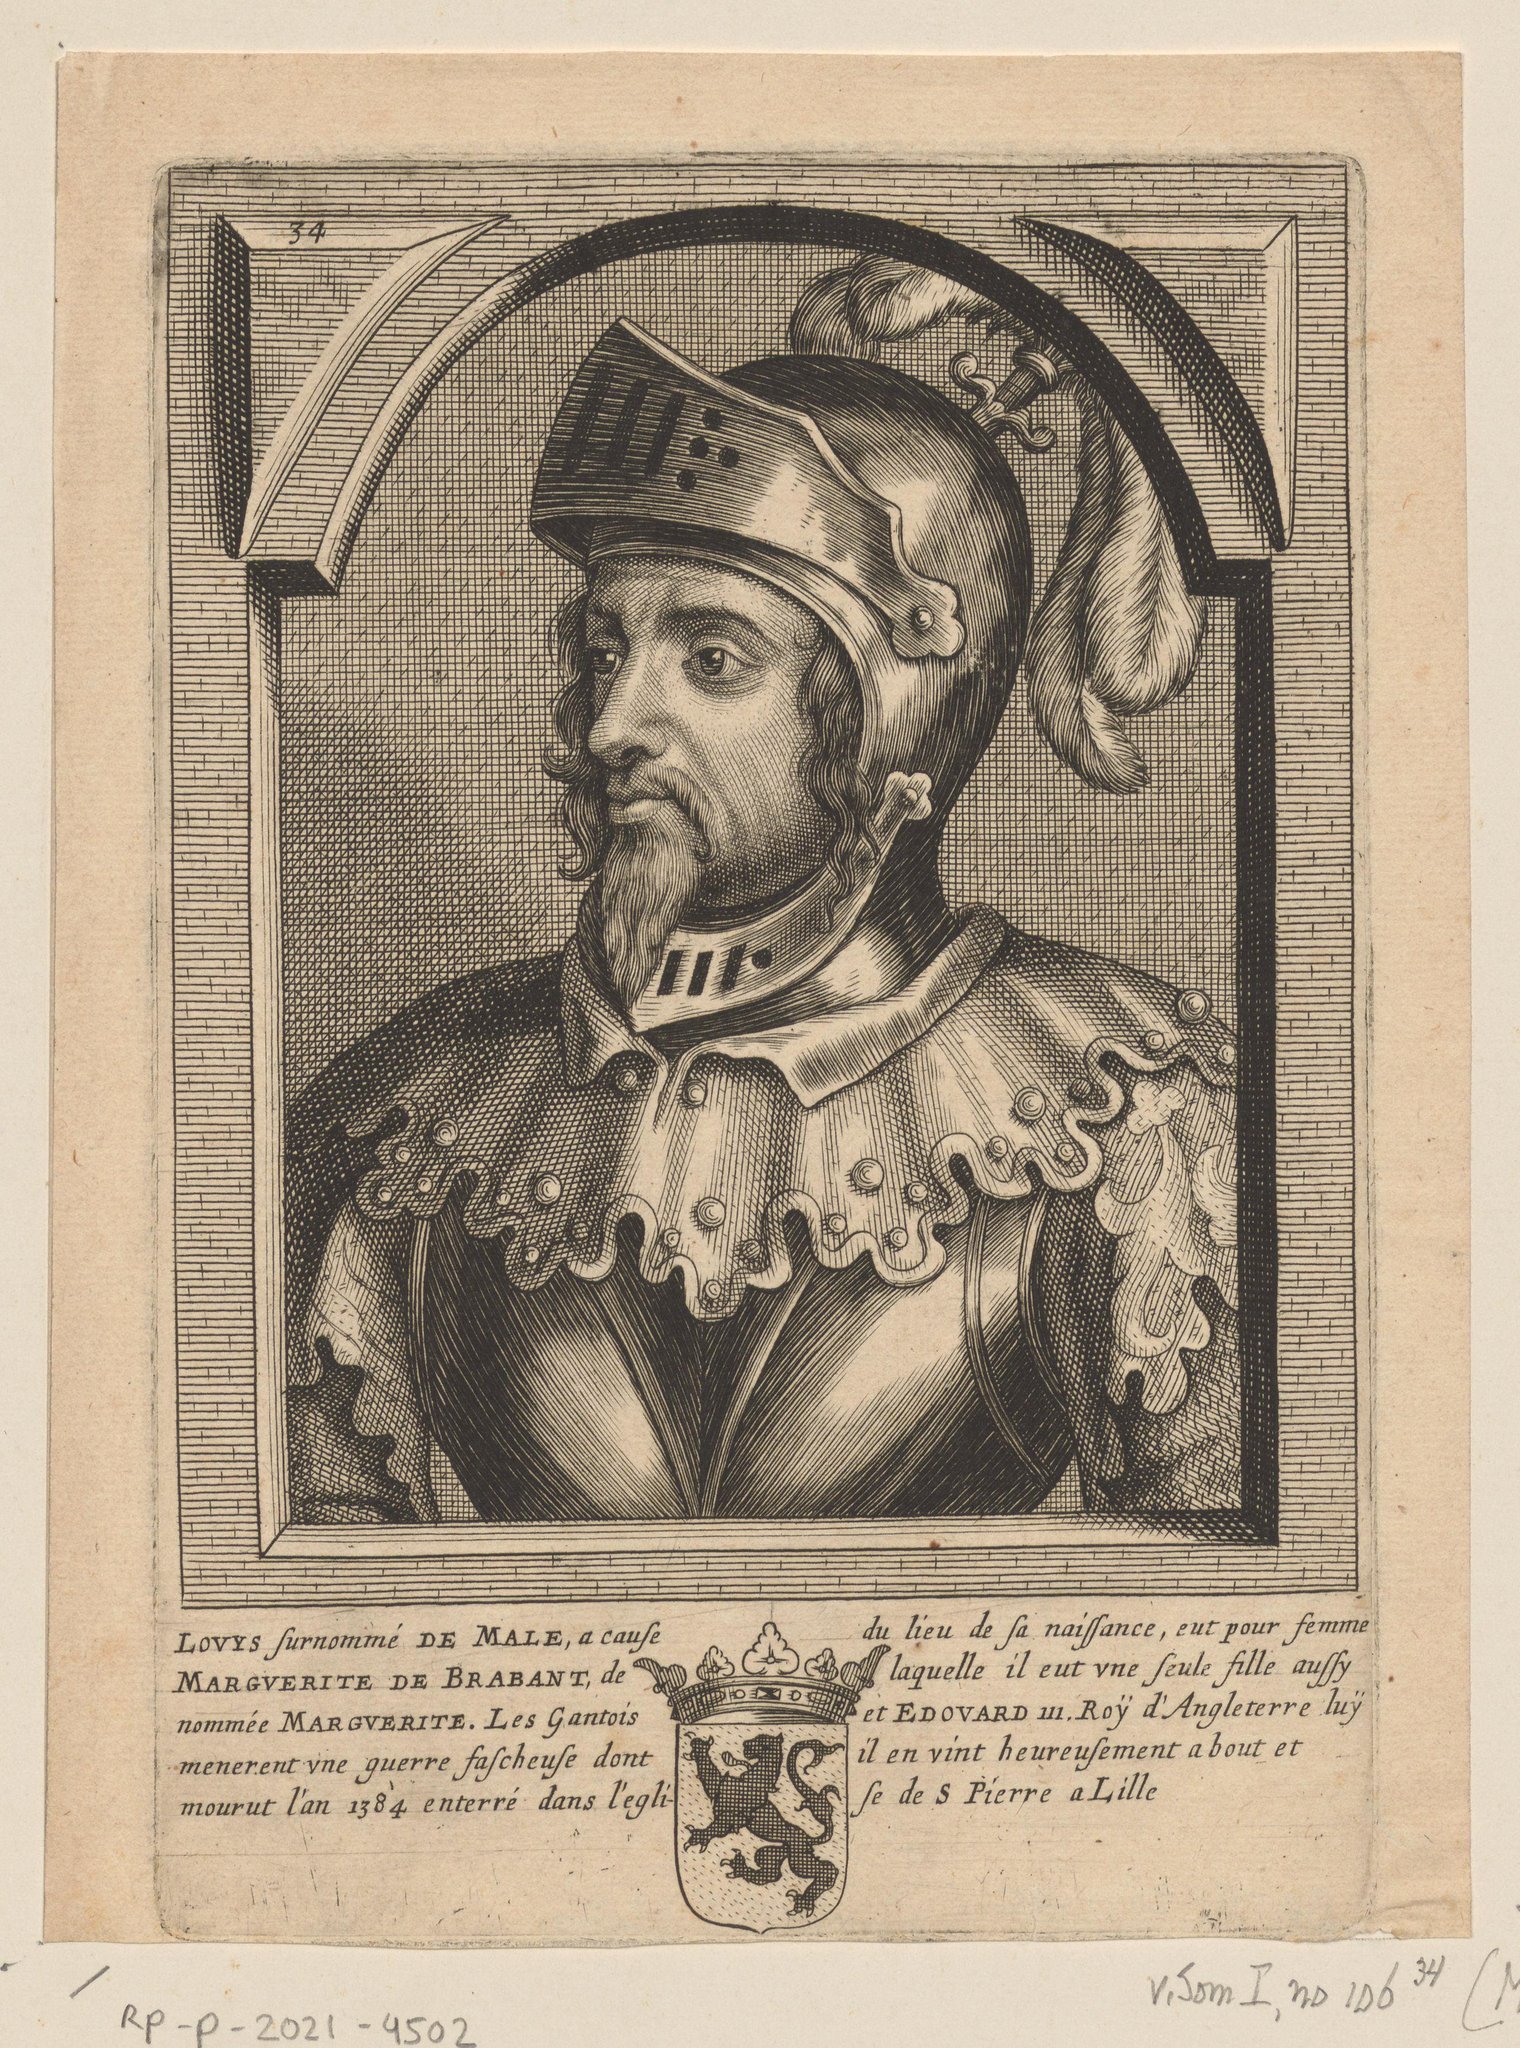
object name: print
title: Effigies des Forestiers et Comtes de Flandres (...)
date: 1663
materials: paper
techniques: engraving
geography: antwerp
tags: bruges, earl, armour, historical persons, armorial bearing, heraldry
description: Linksboven genummerd: 34. Met onderschrift in het Frans.